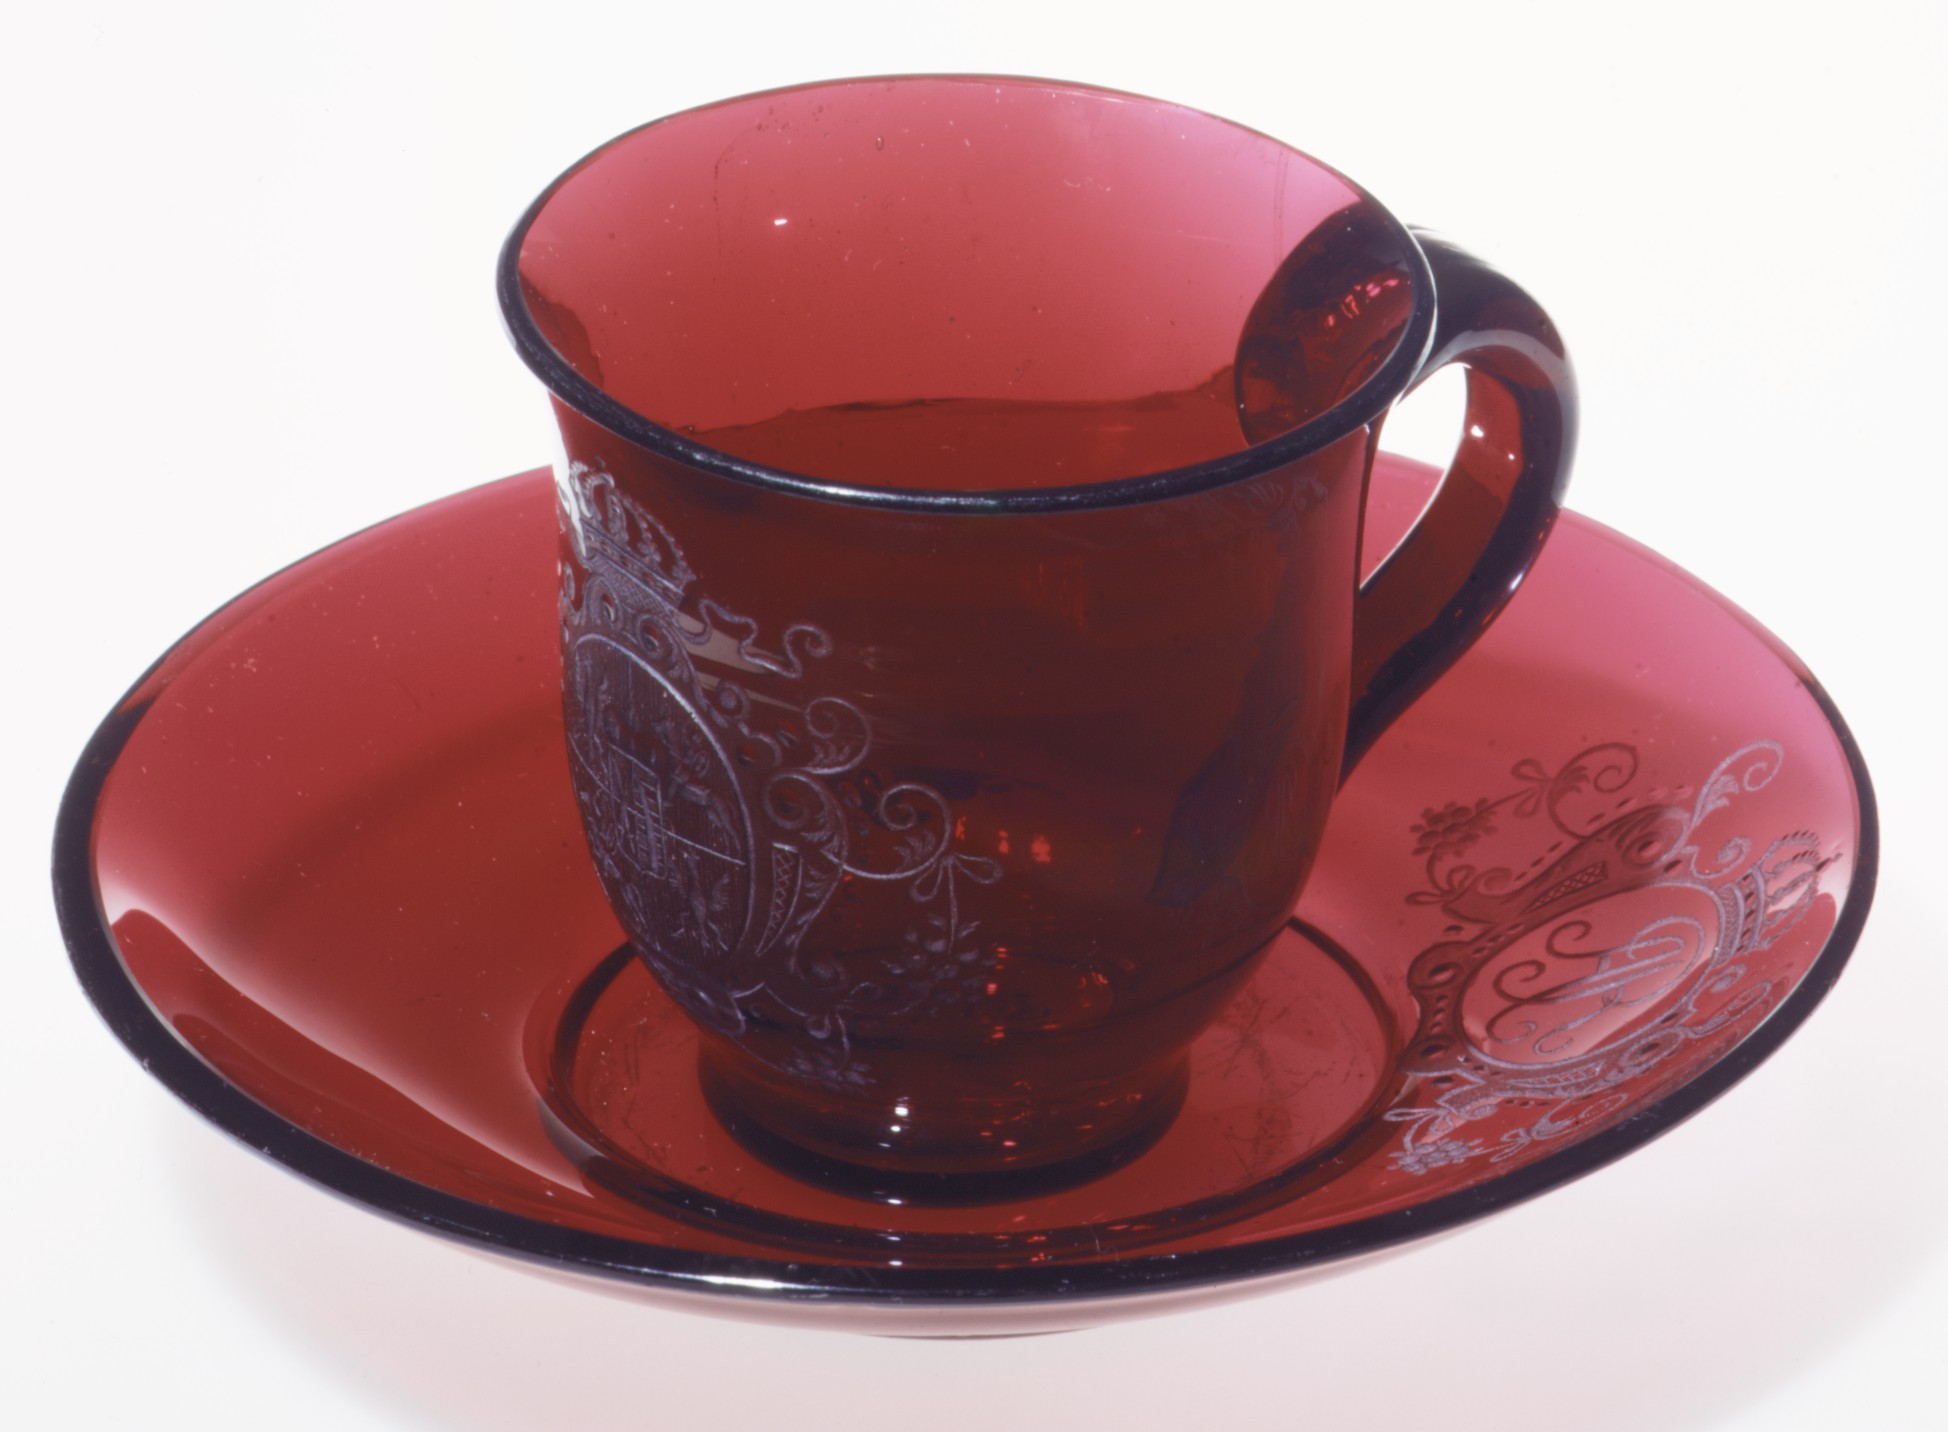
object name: cup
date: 1730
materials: glass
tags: coat of arms